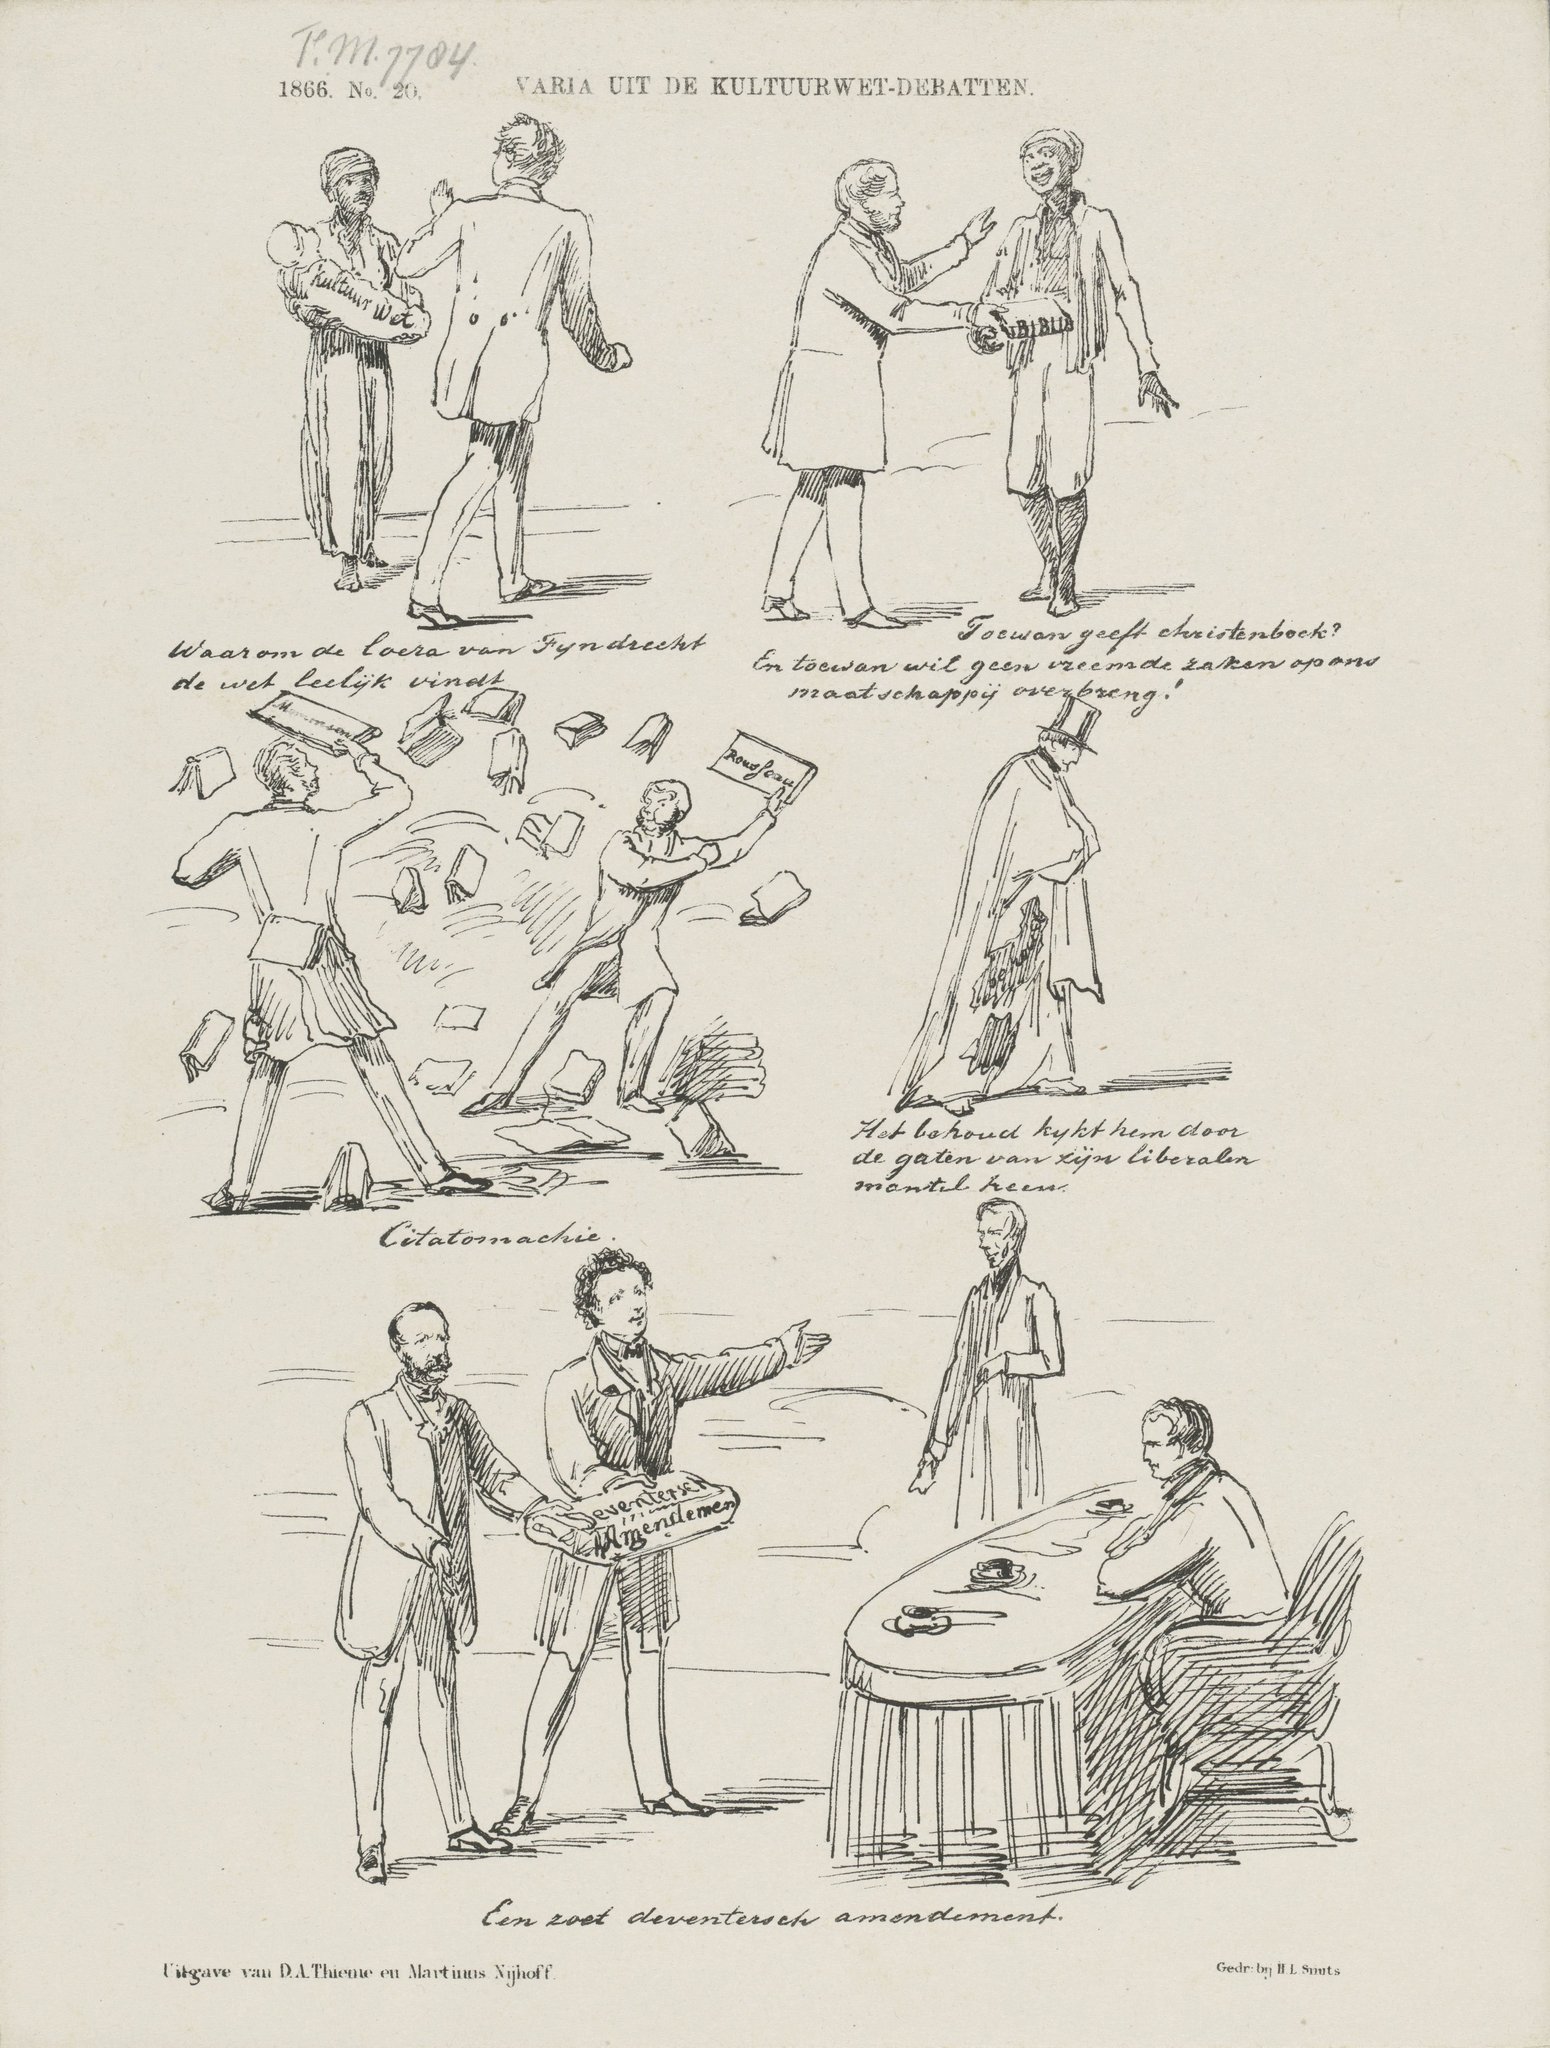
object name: cartoon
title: Spotprent op de debatten over de cultuurwet, 1866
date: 1866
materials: paper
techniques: lithograph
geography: netherlands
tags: debate, discussion (~ parliament)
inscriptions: collector's mark: Lugt 2228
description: Spotprent over de debatten in de Tweede Kamer over de cultuurwet. Plaat verschenen bij het weekblad De Nederlandsche Spectator, nr. 20, 19 mei 1866.